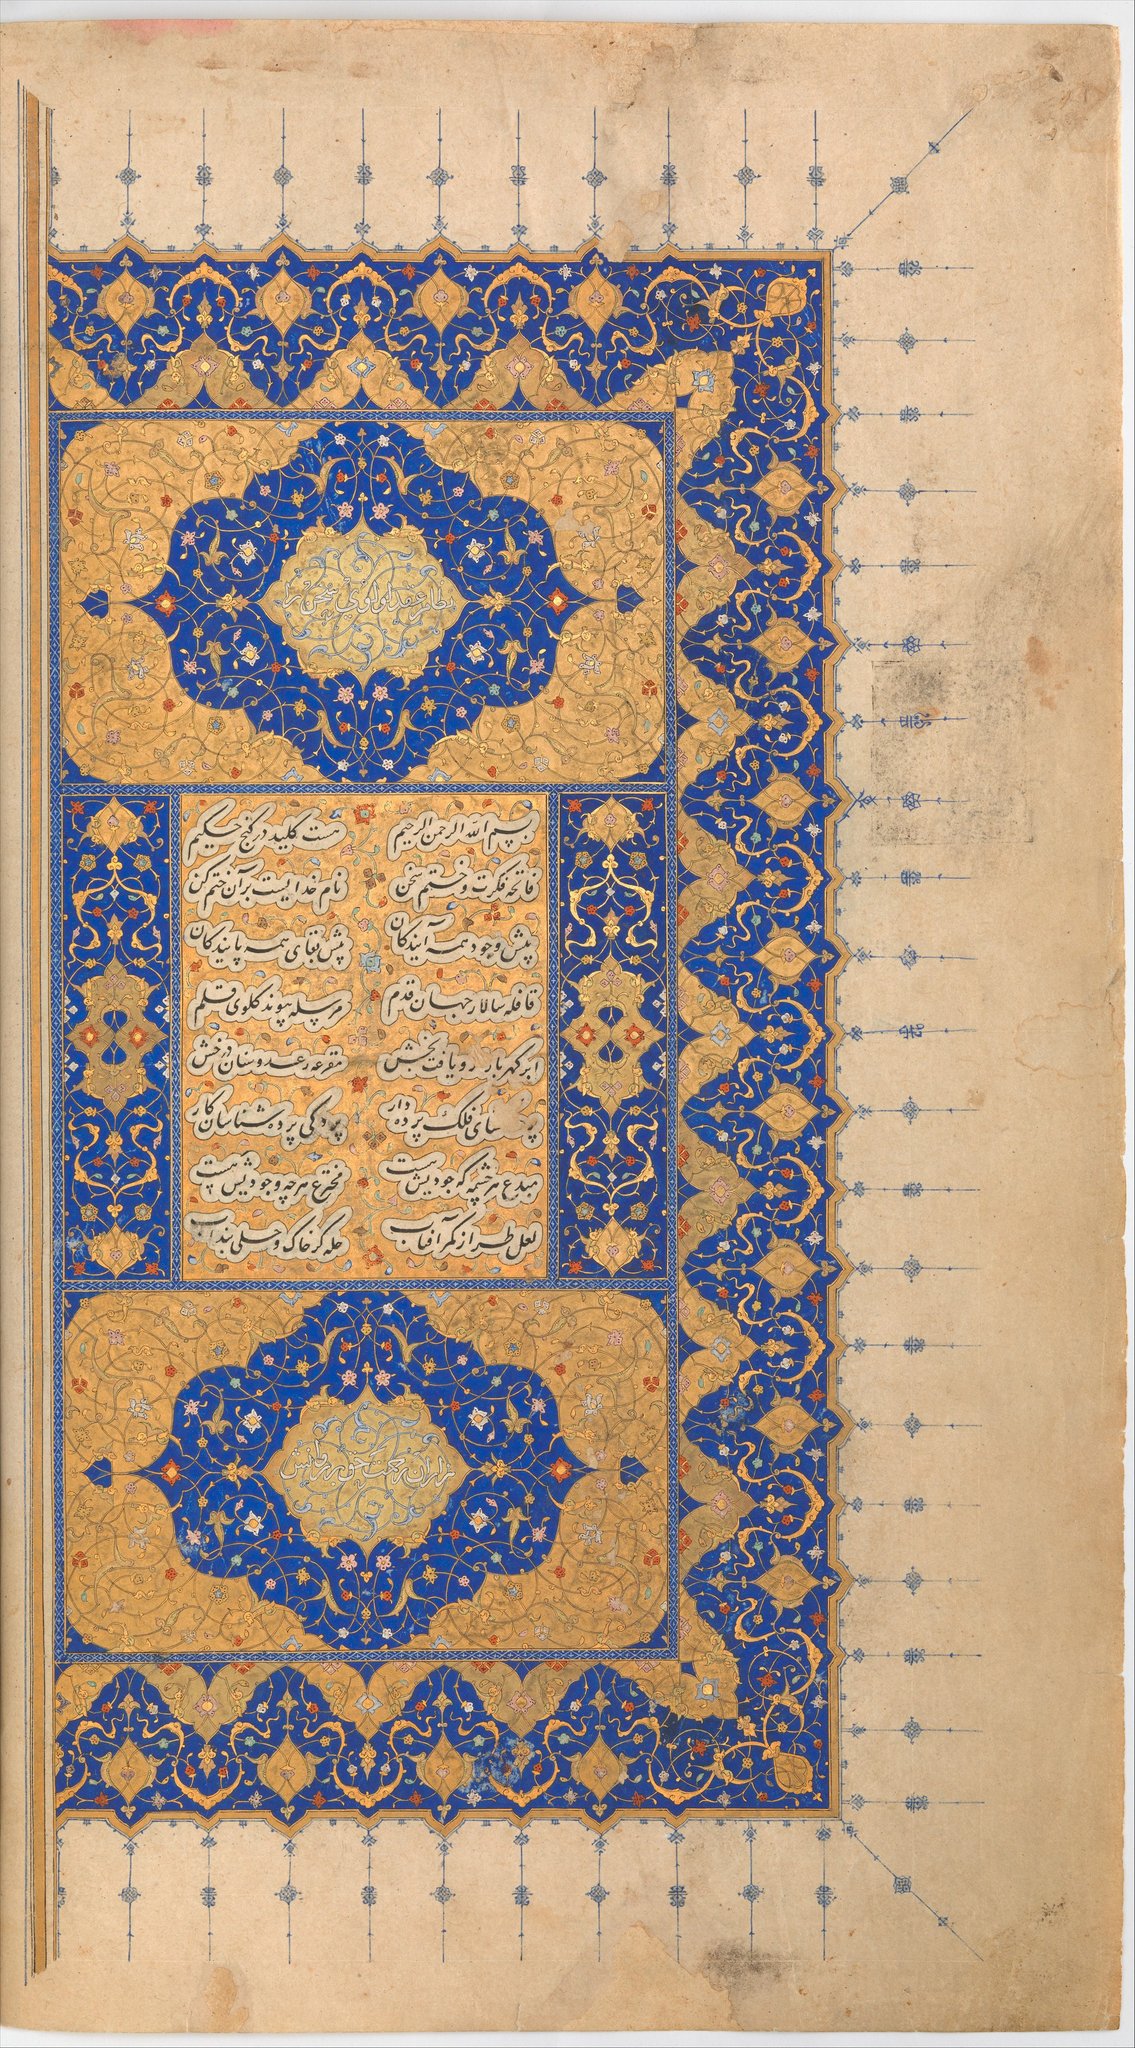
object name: illustrated manuscript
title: Khamsa (Quintet) of Nizami of Ganja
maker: nizami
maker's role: author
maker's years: 1141-1209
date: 1509-1510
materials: ink, leather, paper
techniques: gilding, tooling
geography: iran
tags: men,horses